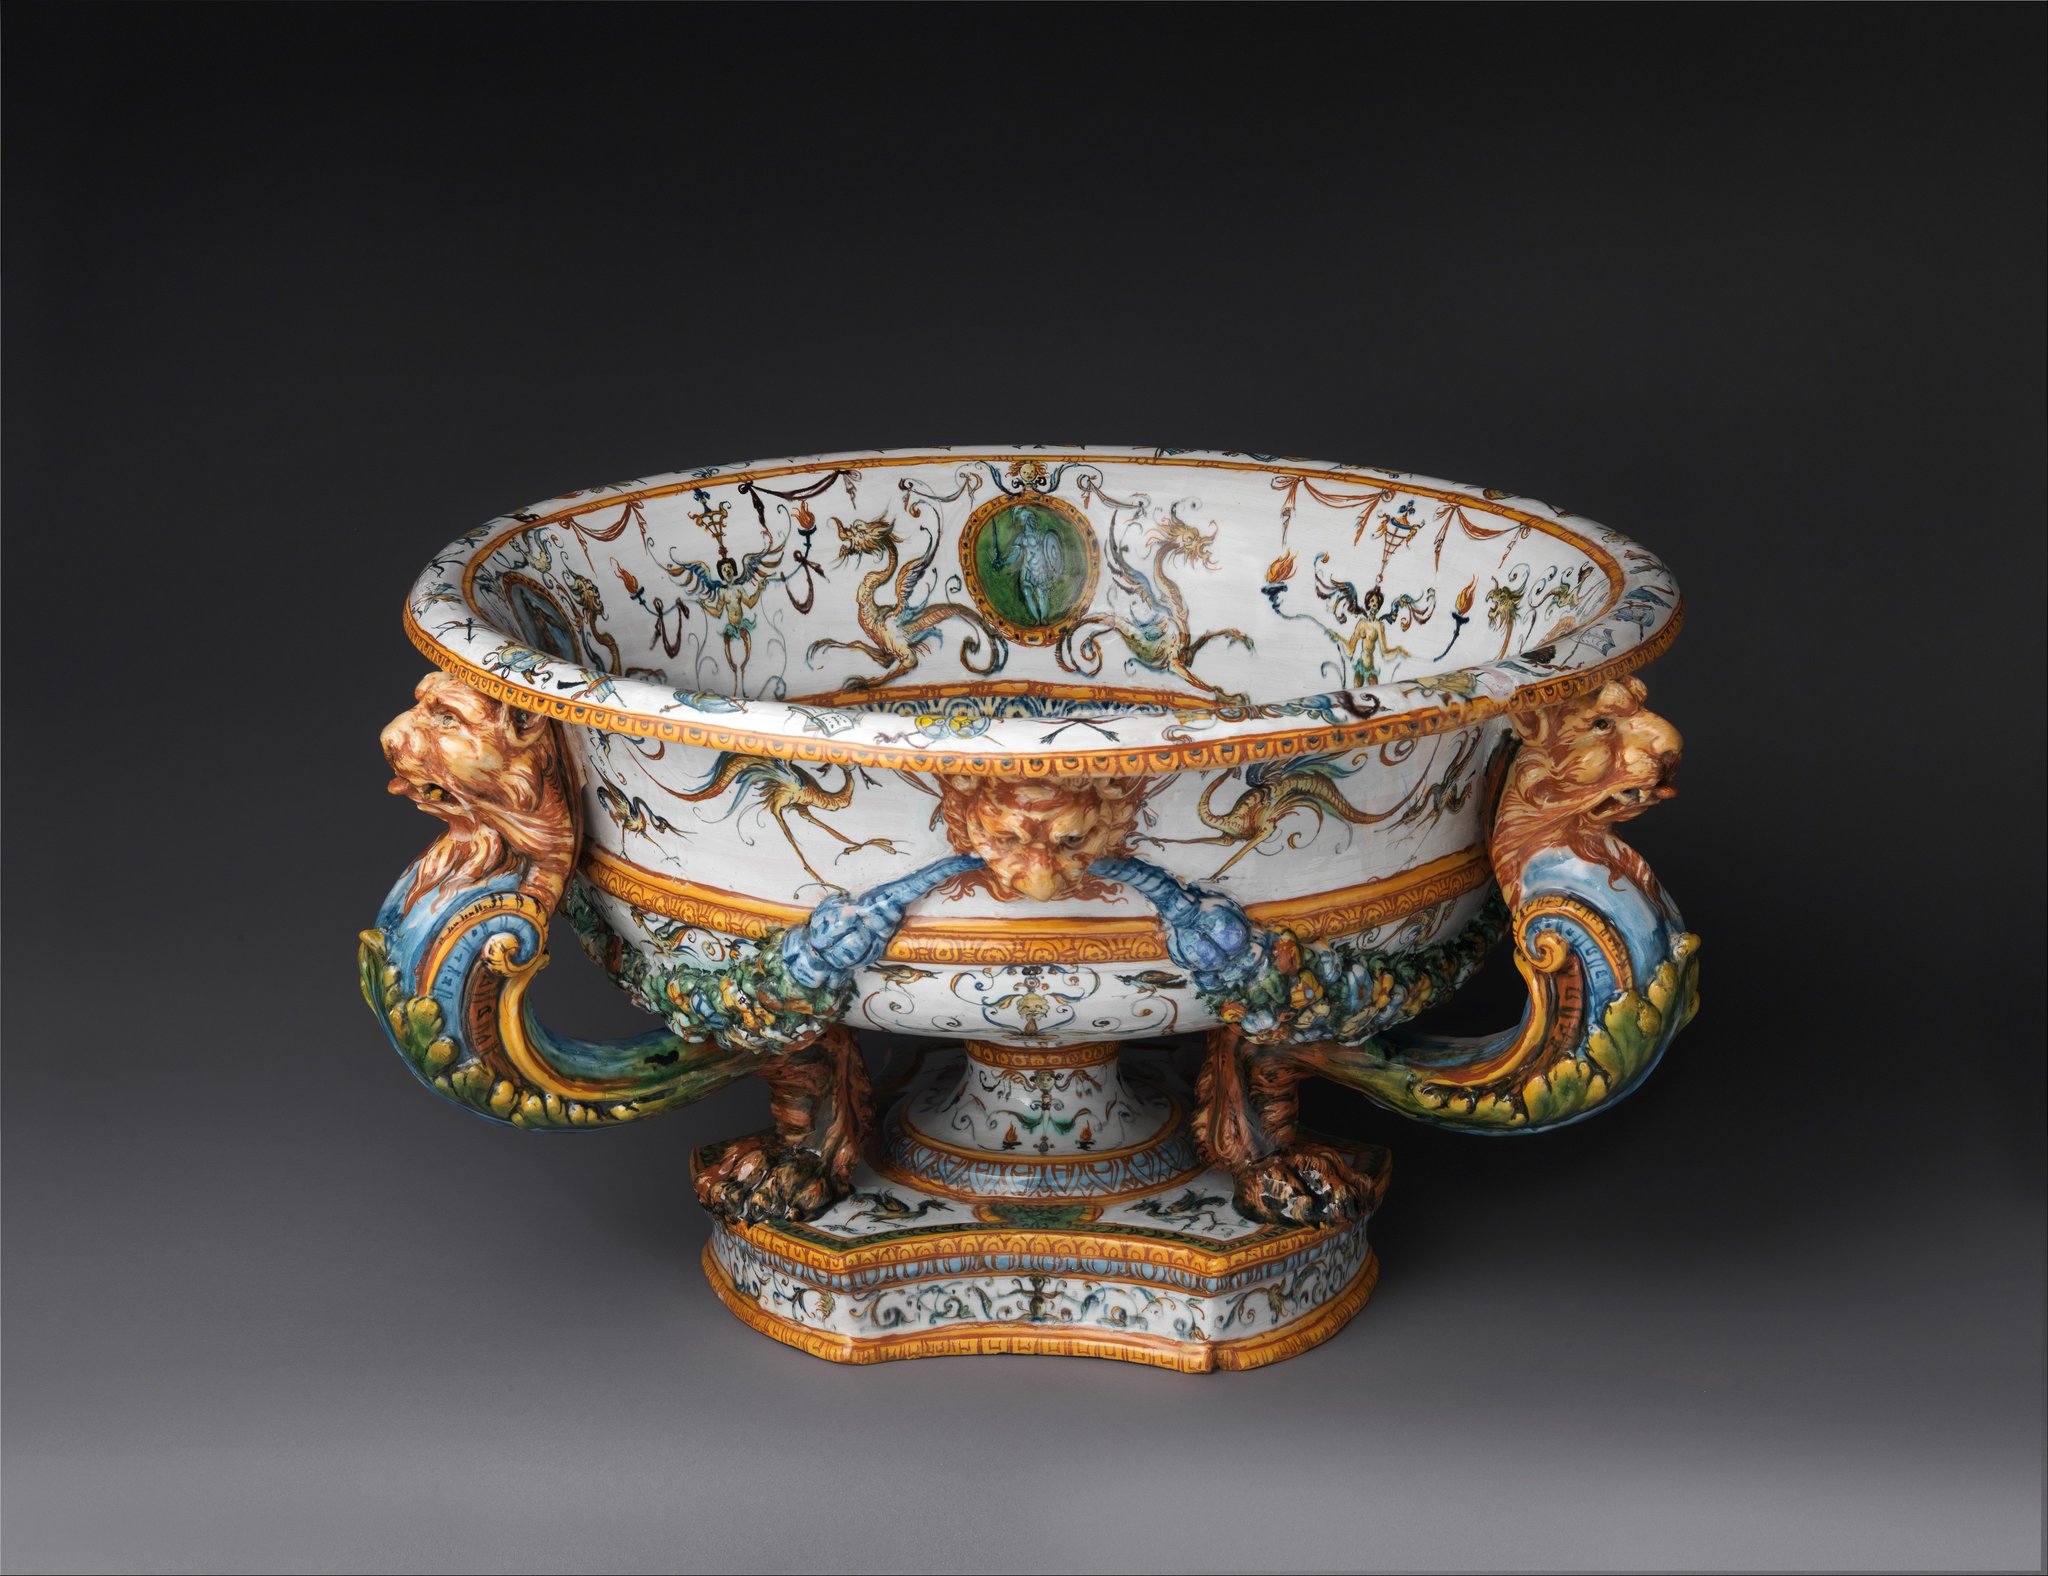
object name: wine cooler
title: Wine cooler with A Pageant Battle with Elephants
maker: fontana family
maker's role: maker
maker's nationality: italian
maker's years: 1548-1585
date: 1562-1575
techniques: maiolica, glazing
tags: battles,men,elephants